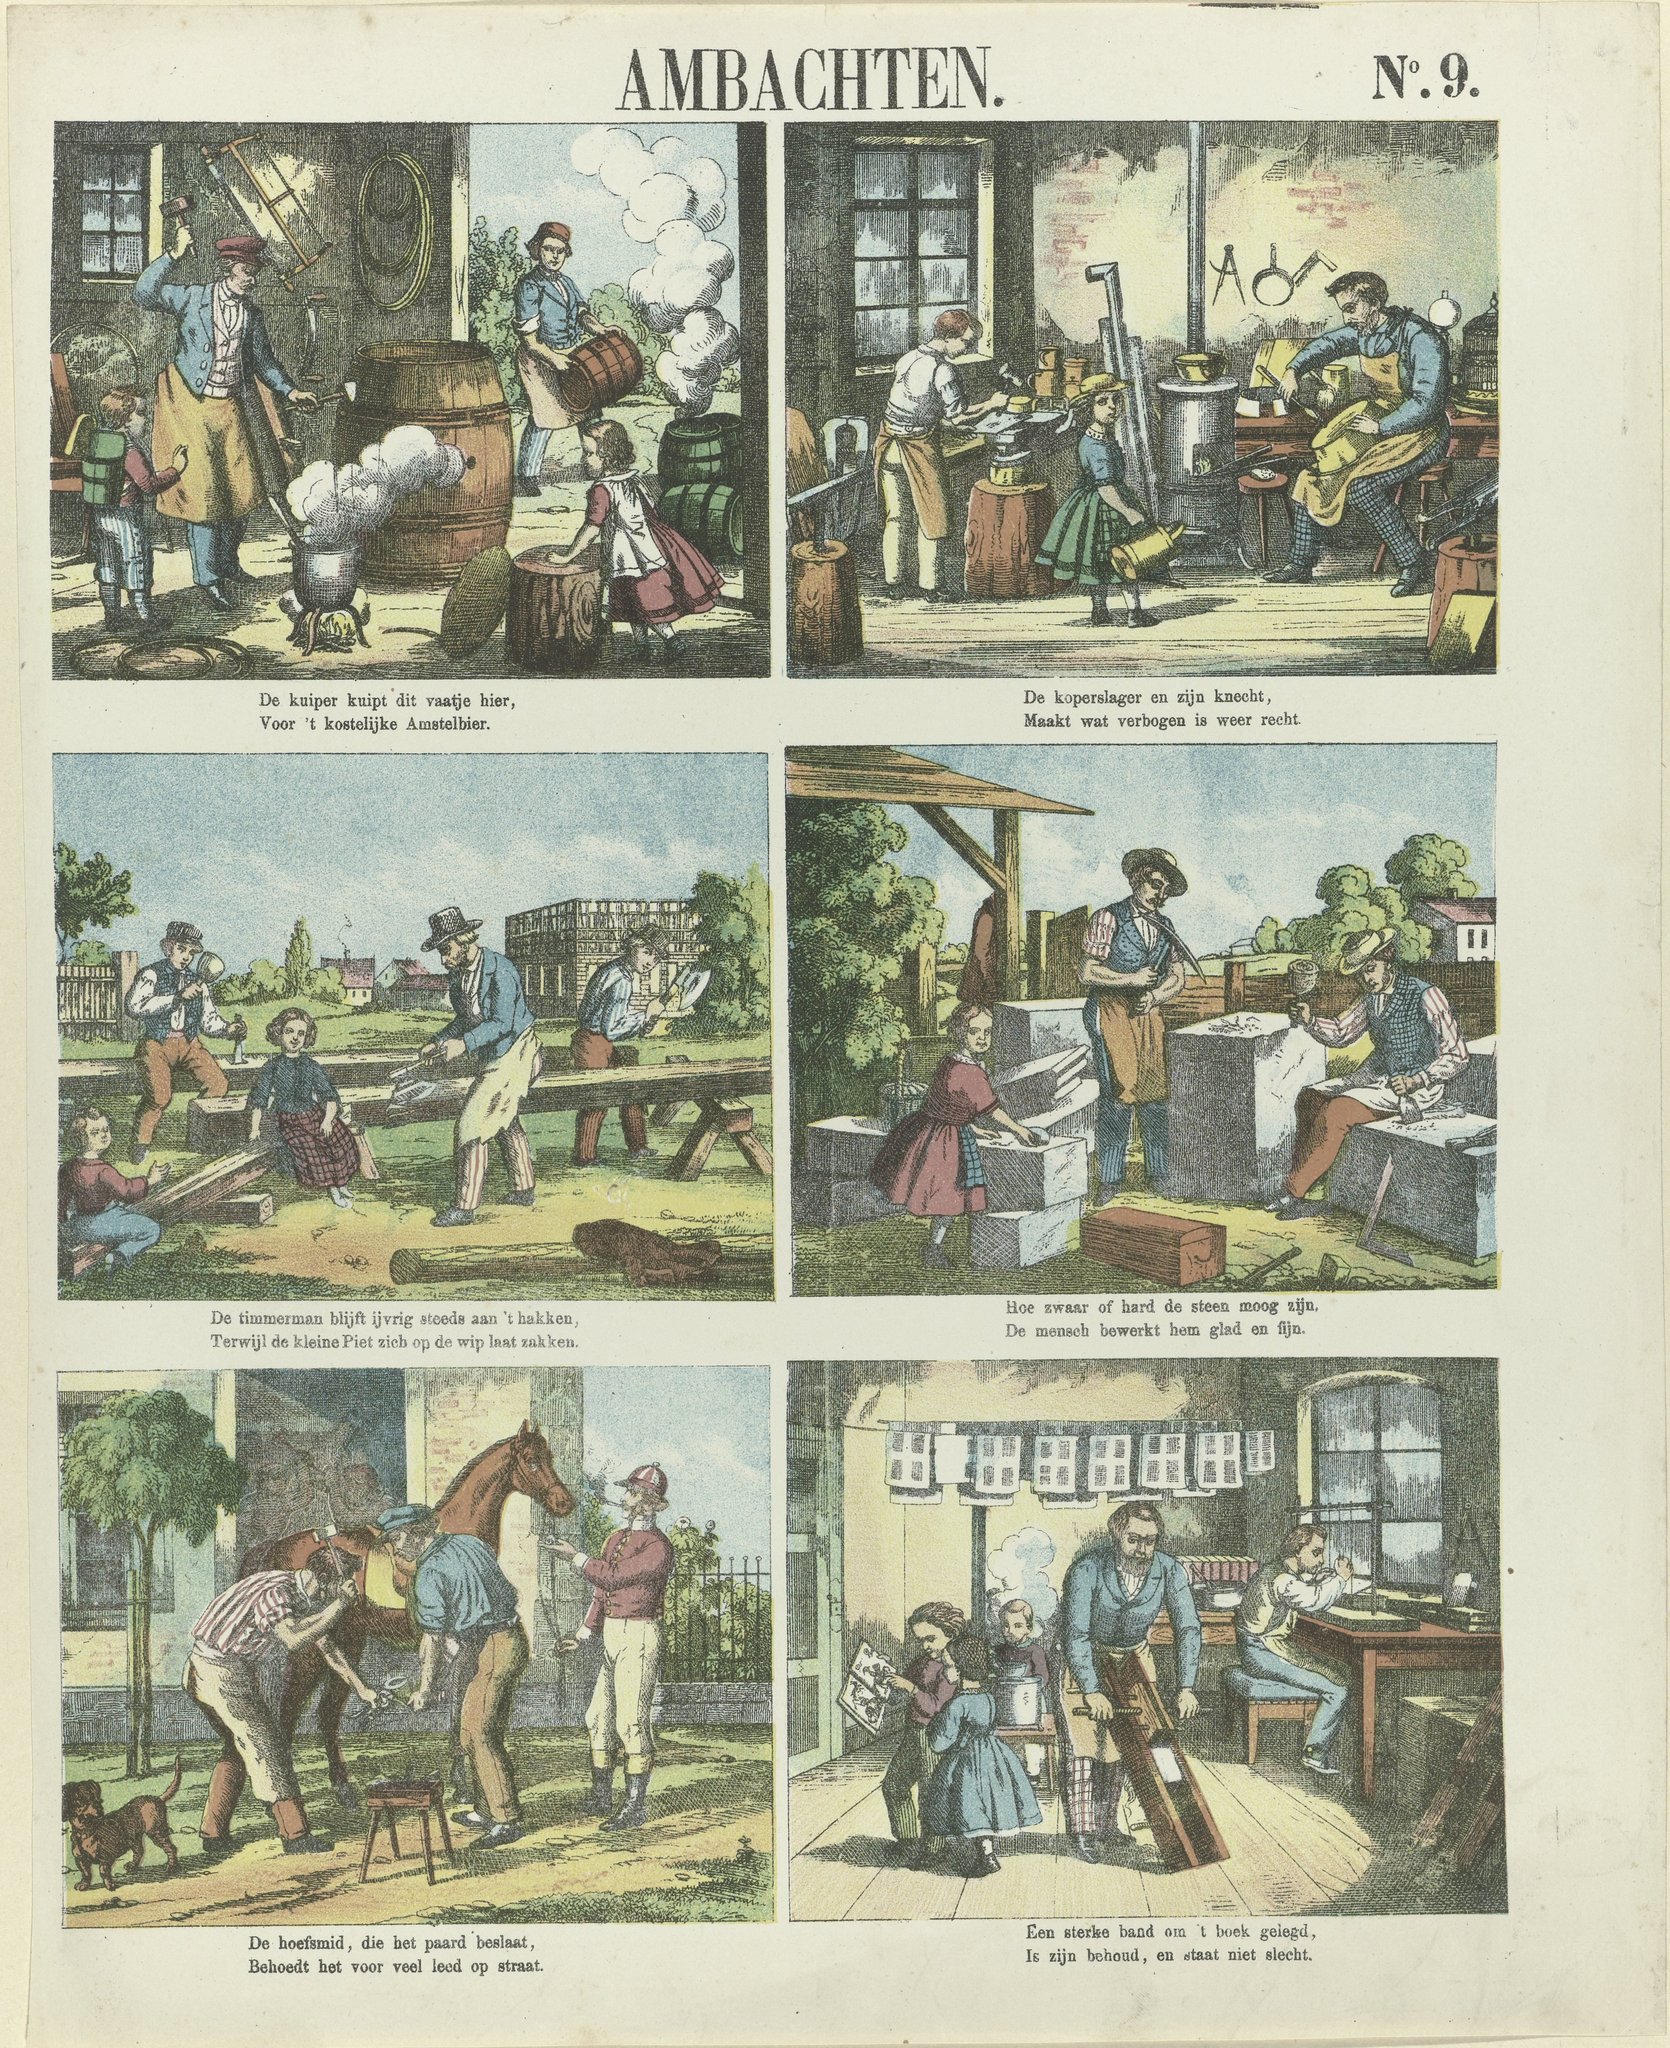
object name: popular print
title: Meijer's prenten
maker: Anonymous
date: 1873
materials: paper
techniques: lithograph, letterpress printing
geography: amsterdam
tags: stone-cutter, stone-sawyer, carpenter, printer, crafts and industries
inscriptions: collector's mark: Lugt 2760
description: Blad met 6 voorstellingen van ambachtslieden, zoals kuiper, koperslager, timmerman en boekdrukker. Onder elke afbeelding een tweeregelig vers. Genummerd rechtsboven: No. 9.